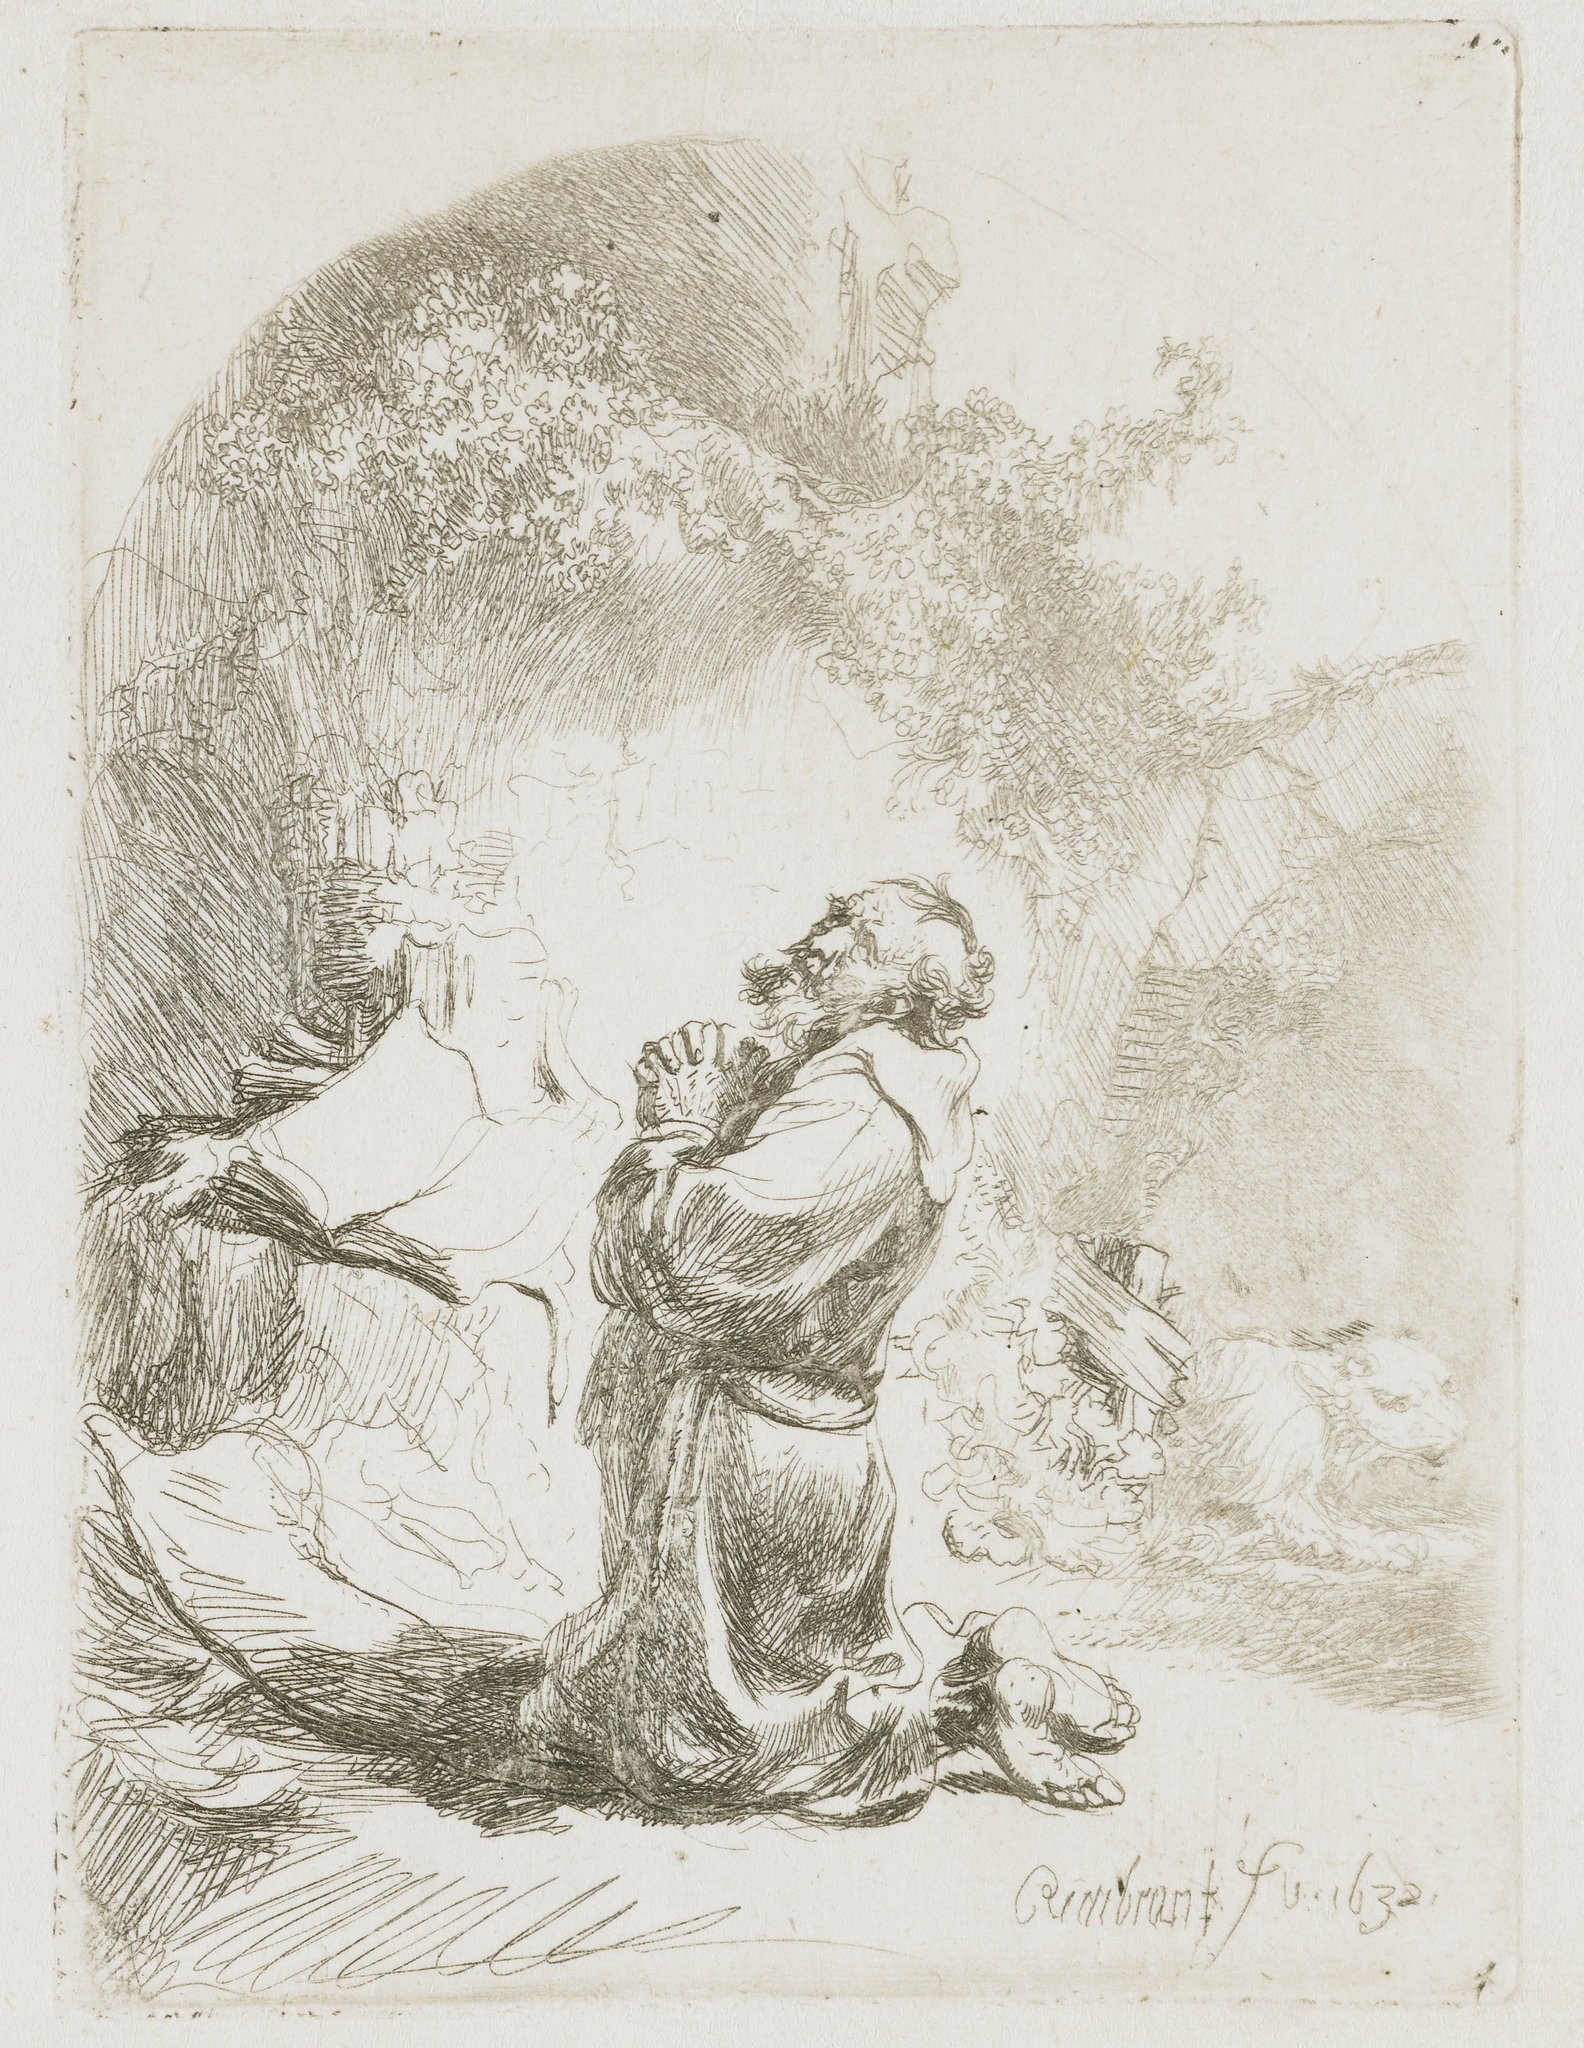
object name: print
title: St Jerome praying: arched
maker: rembrandt van rijn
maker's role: draughtsman, painter, print maker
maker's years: 1606-1669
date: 1632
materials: paper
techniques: etching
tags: (private) prayer; 'oratione', 'preghiere', 'preghiere a dio' (ripa), the monk and hermit jerome (hieronymus); possible attributes: book, cardinal's hat, crucifix, hour-glass, lion, skull, stone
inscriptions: signature and date: ‘Rembrandt f. 1632’, collector's mark: Lugt 2228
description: B.101; 1e staat versleten veil. Sotheby 1930